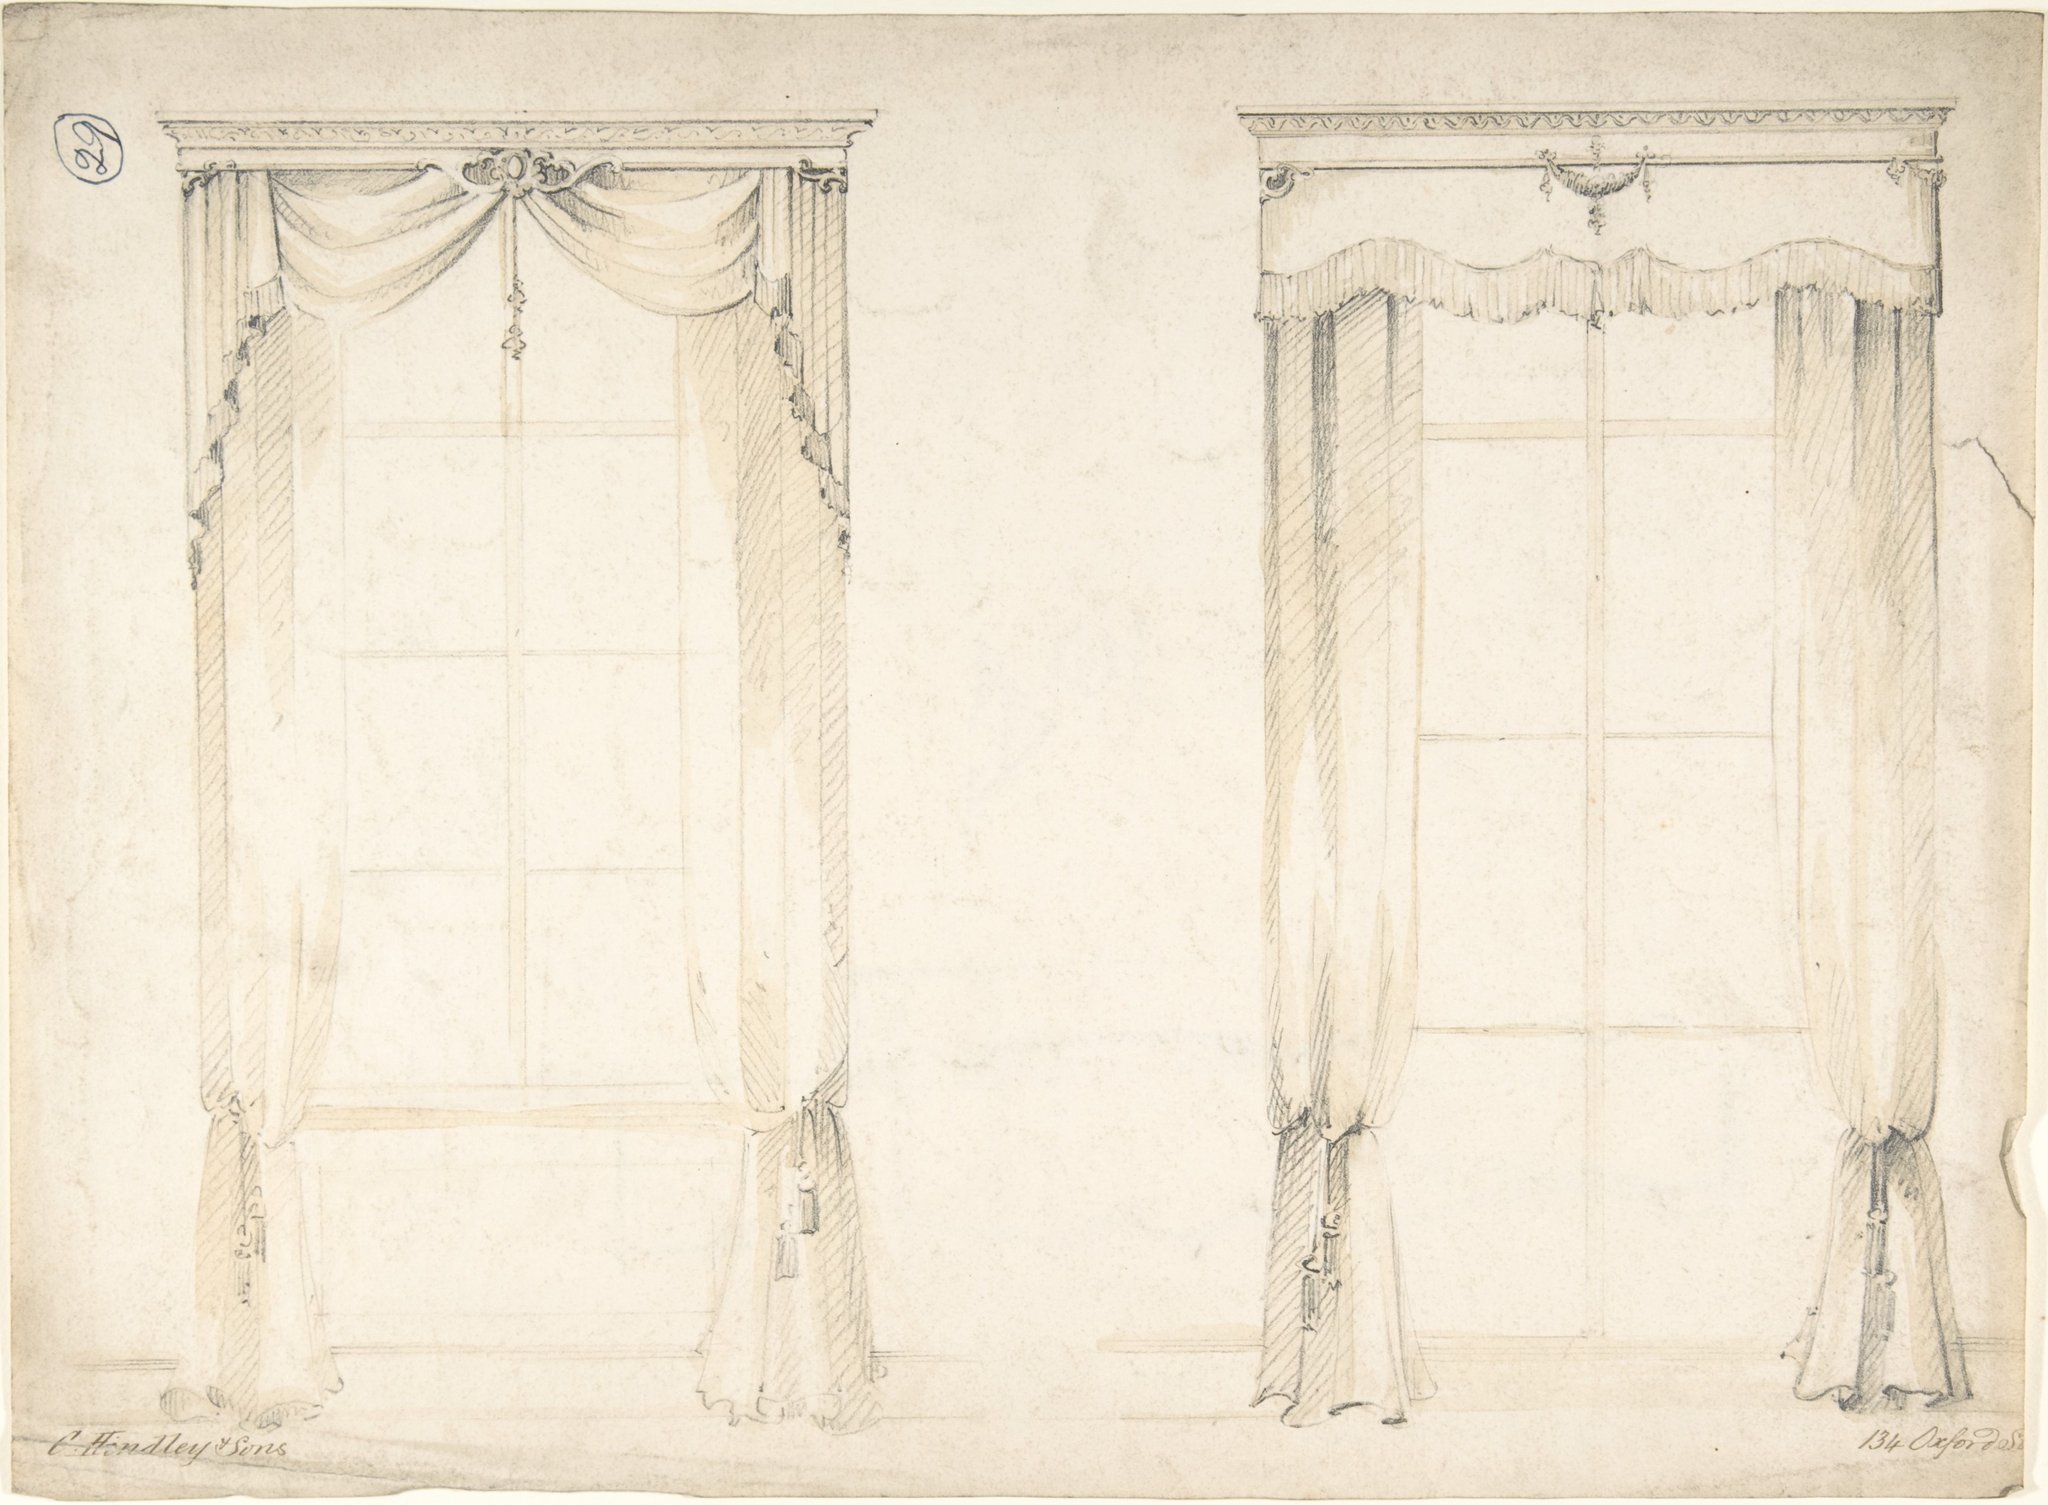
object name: drawing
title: Designs for Two Sets of Curtains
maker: charles hindley and sons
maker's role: artist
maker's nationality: british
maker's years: 1841-1917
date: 1841-1884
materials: graphite, watercolor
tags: curtains